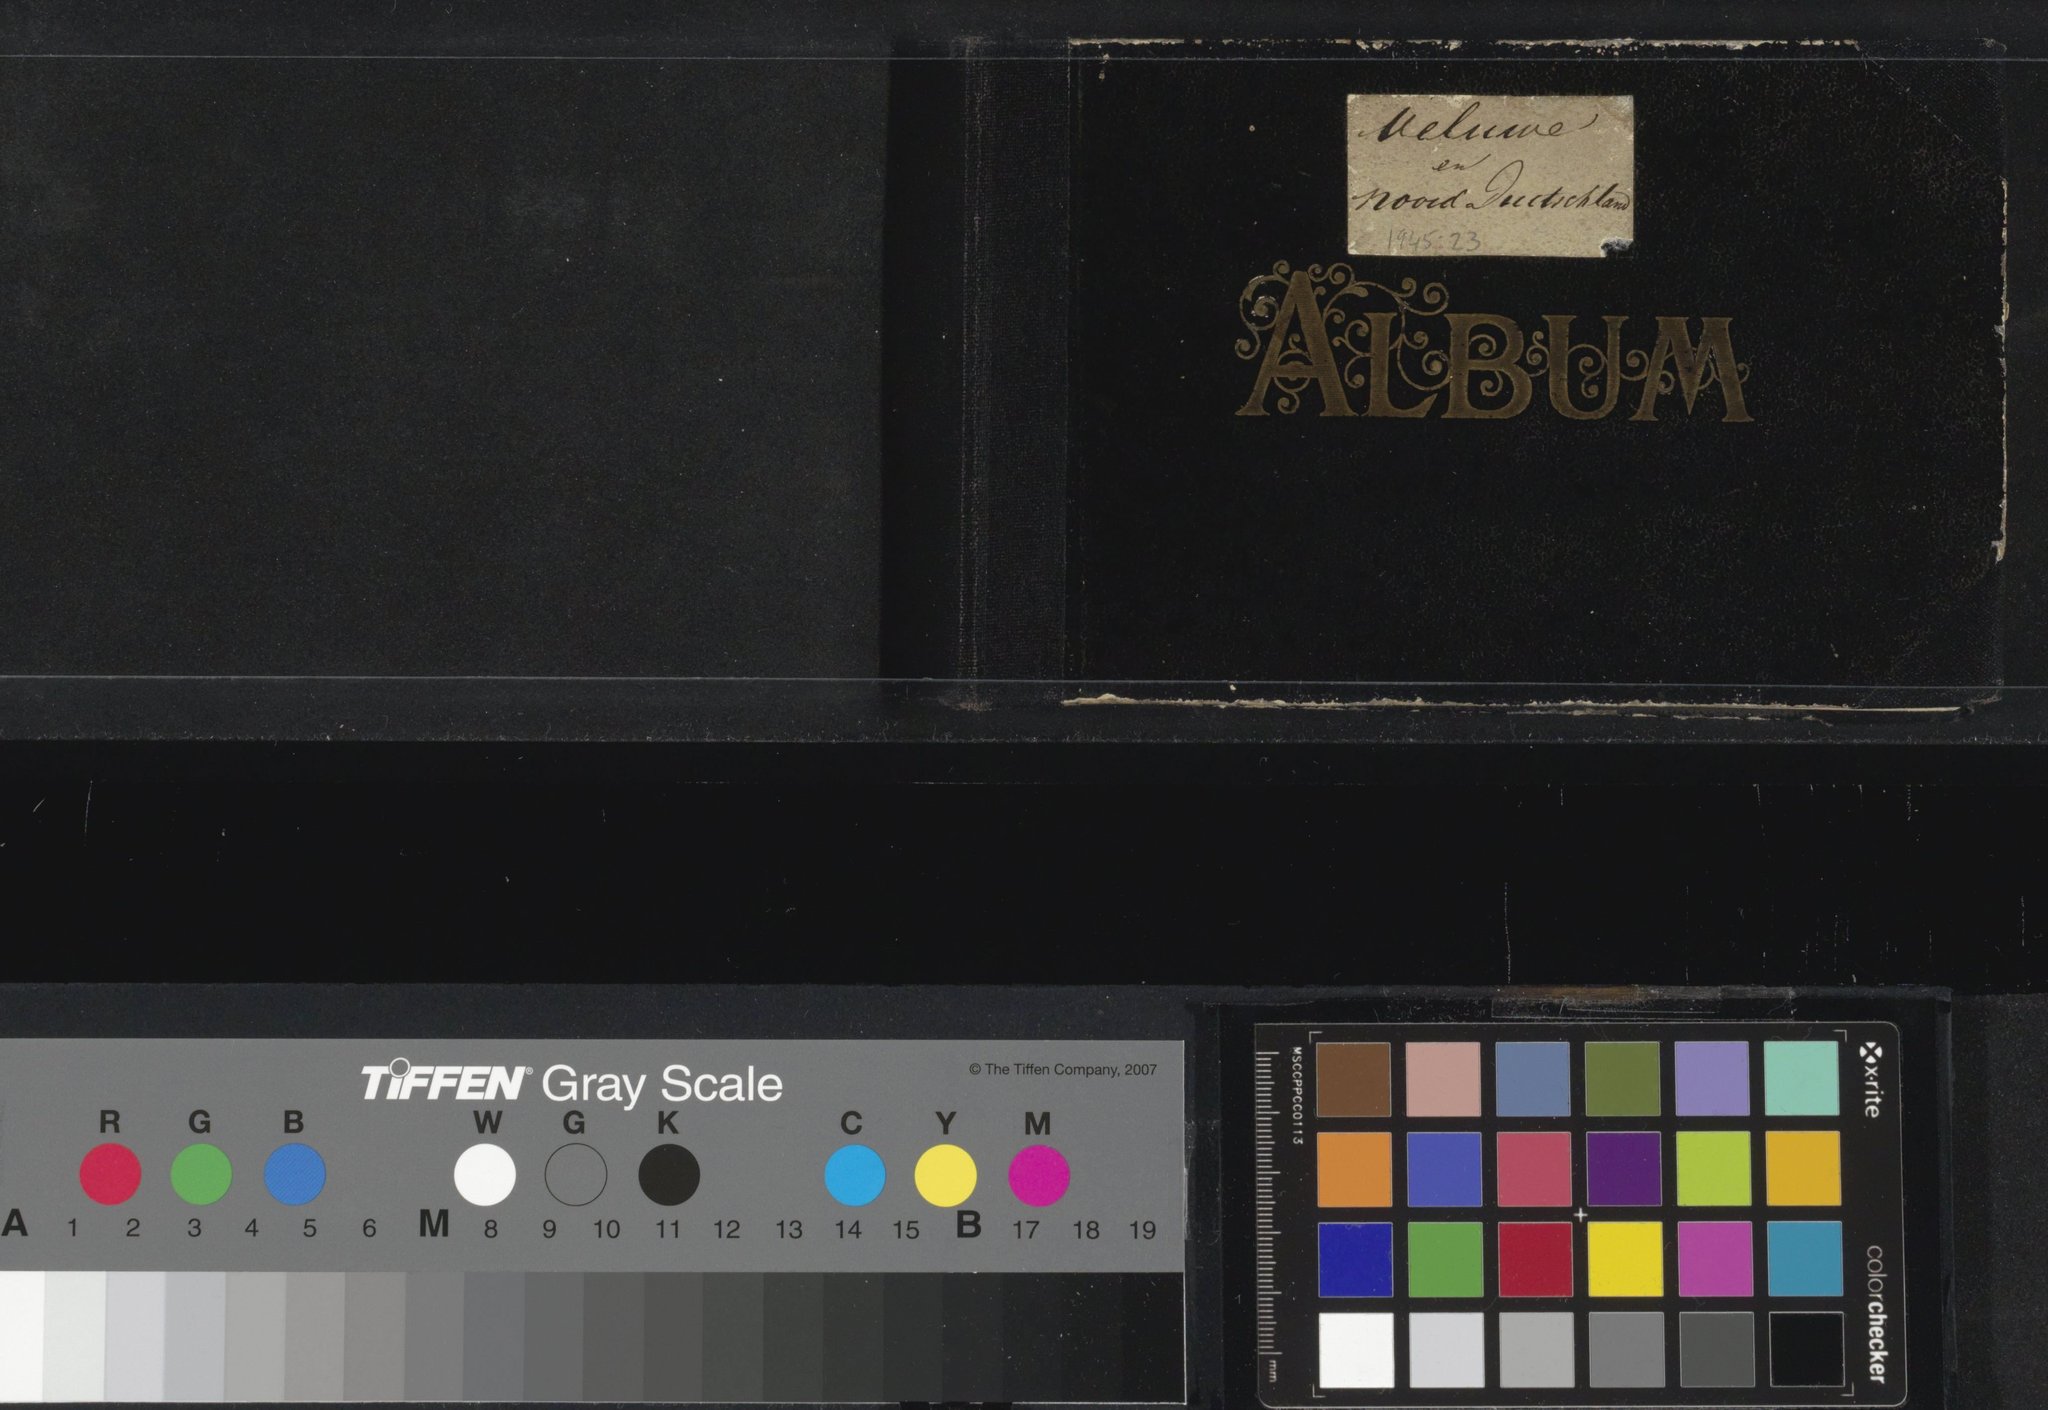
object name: sketchbook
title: Schetsboek met 55 bladen vervaardigd op de Veluwe en in Noord-Duitsland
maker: cornelis springer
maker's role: draughtsman, painter, print maker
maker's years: 1817-1891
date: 1863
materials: linen, paper, pencil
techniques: manufacturing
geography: north germany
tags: city-view, and landscape with man-made constructions, man in a general biological sense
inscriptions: signature: ‘C Springer/ Amsterdam’, annotation: ‘Veluwe/ en/ Noord Duitschland’, collector's mark: Lugt 2228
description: Schetsboek bestaande uit 55 bladen vervaardigd op de Veluwe en in Noord-Duitsland met stadsgezichten, landschappen, figuren en klederdracht. Topografische annotaties: Elburg, Harderwijk, Ermelo, Buren, Bremen en Emden.